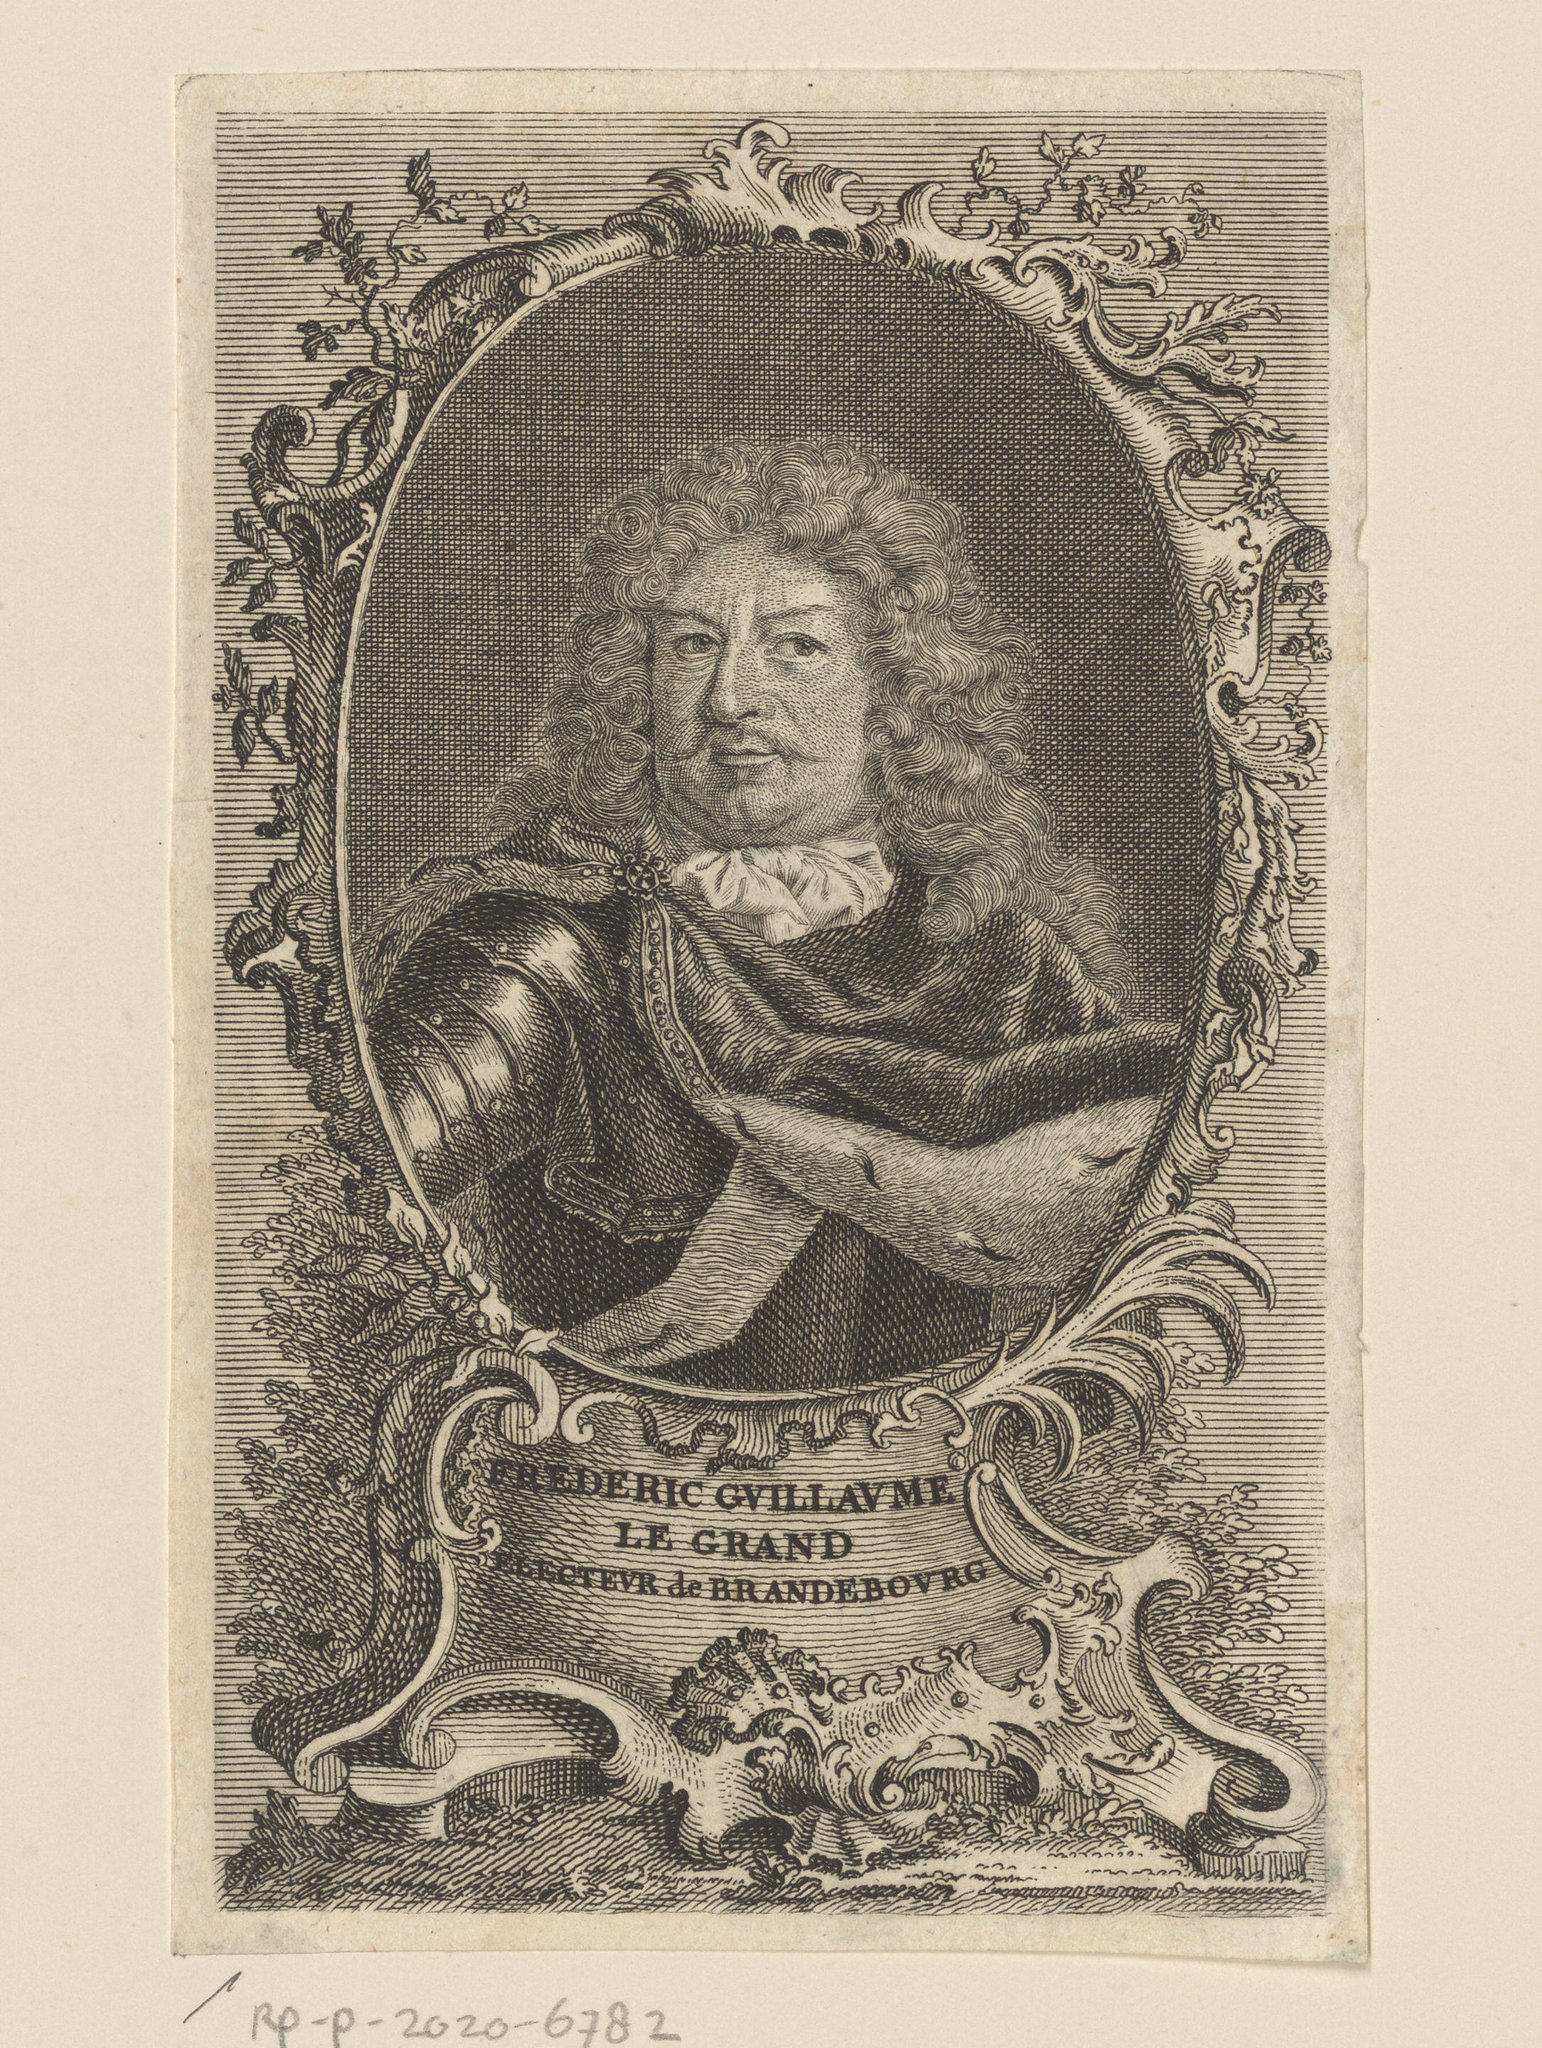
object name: print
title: Portret van Frederik Willem I van Brandenburg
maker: Anonymous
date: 1660-1699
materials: paper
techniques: etching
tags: frederik willem van brandenburg (i), rocaille ornament, armour, historical persons